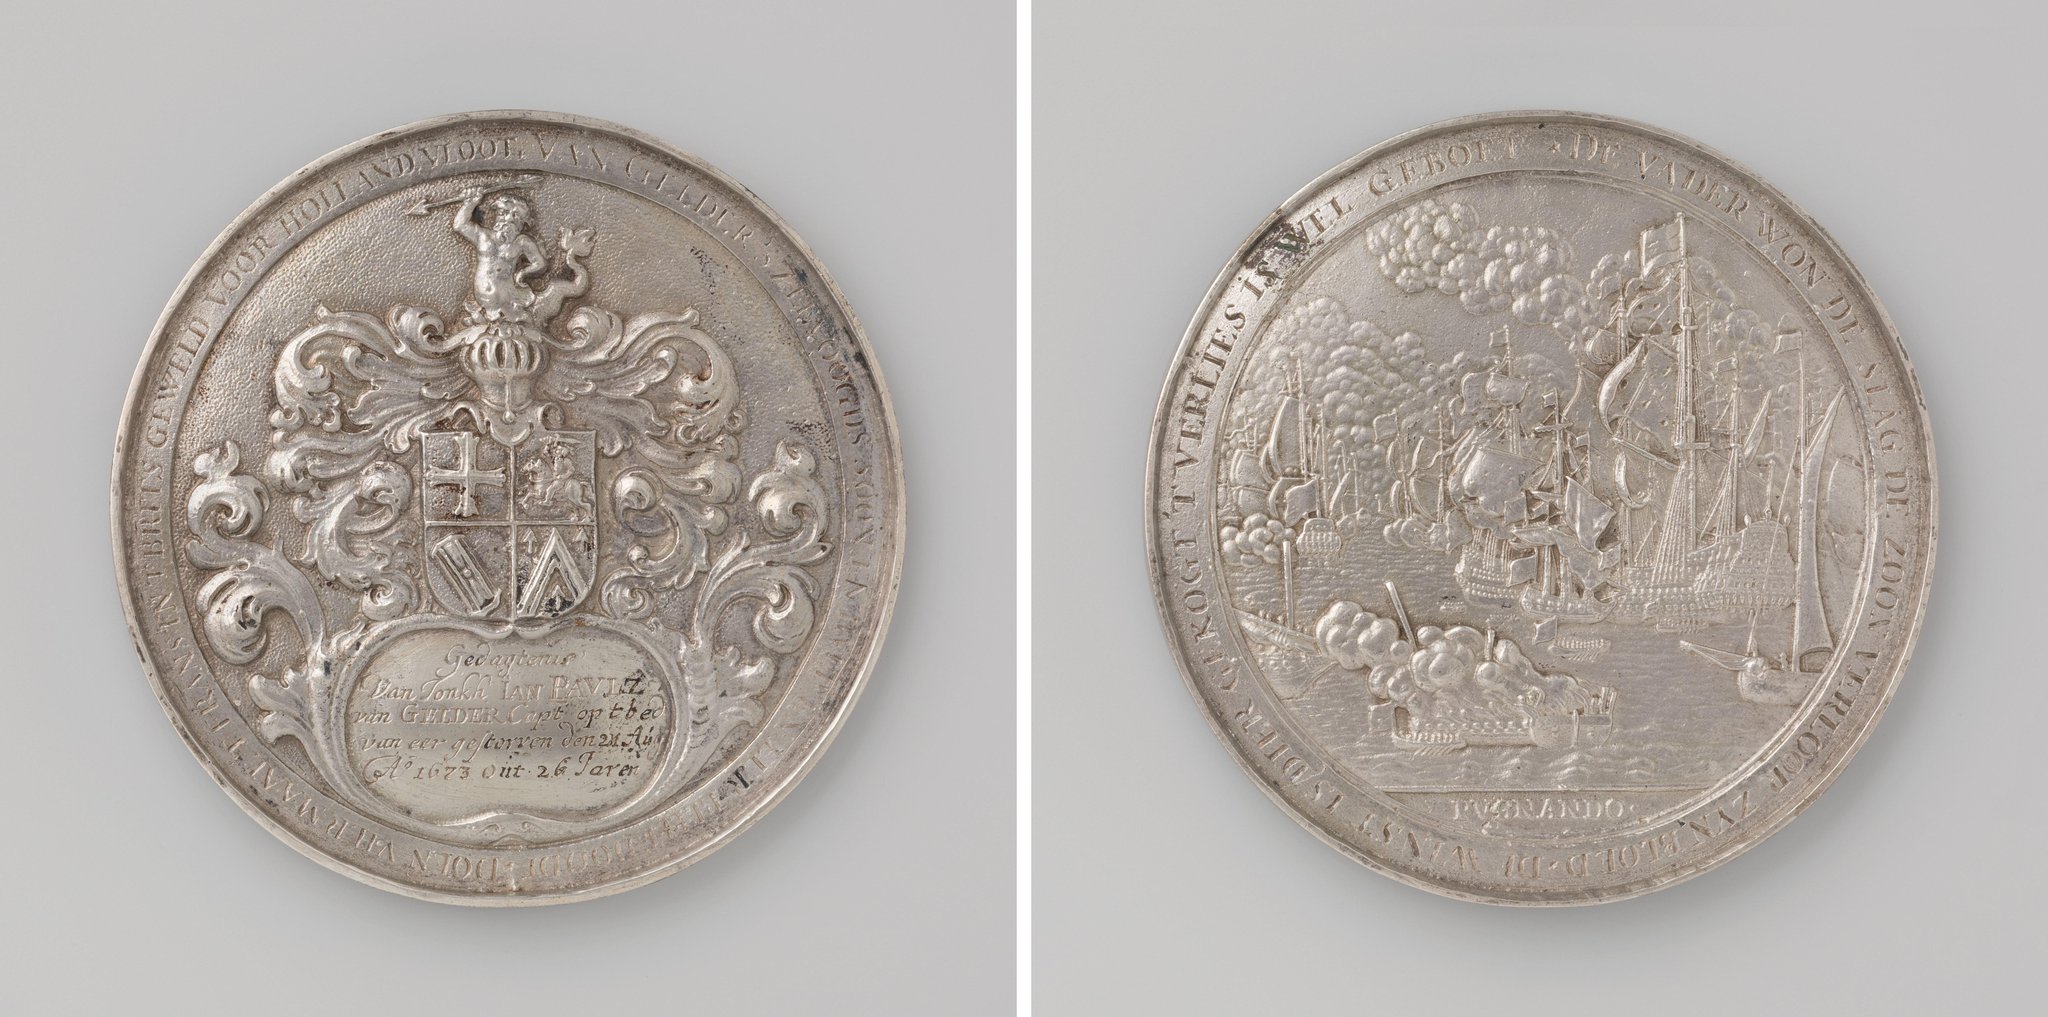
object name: history medal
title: Sneuvelen van kapitein-ter-zee jonkheer Jan van Gelder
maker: Anonymous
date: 1673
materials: silver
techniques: casting, engraving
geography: netherlands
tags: battle of the texel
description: Zilveren penning. Voorzijde: cartouche met opschrift onder gehelmd wapenschild binnen omschrift. Keerzijde: zeeslag binnen omschrift.